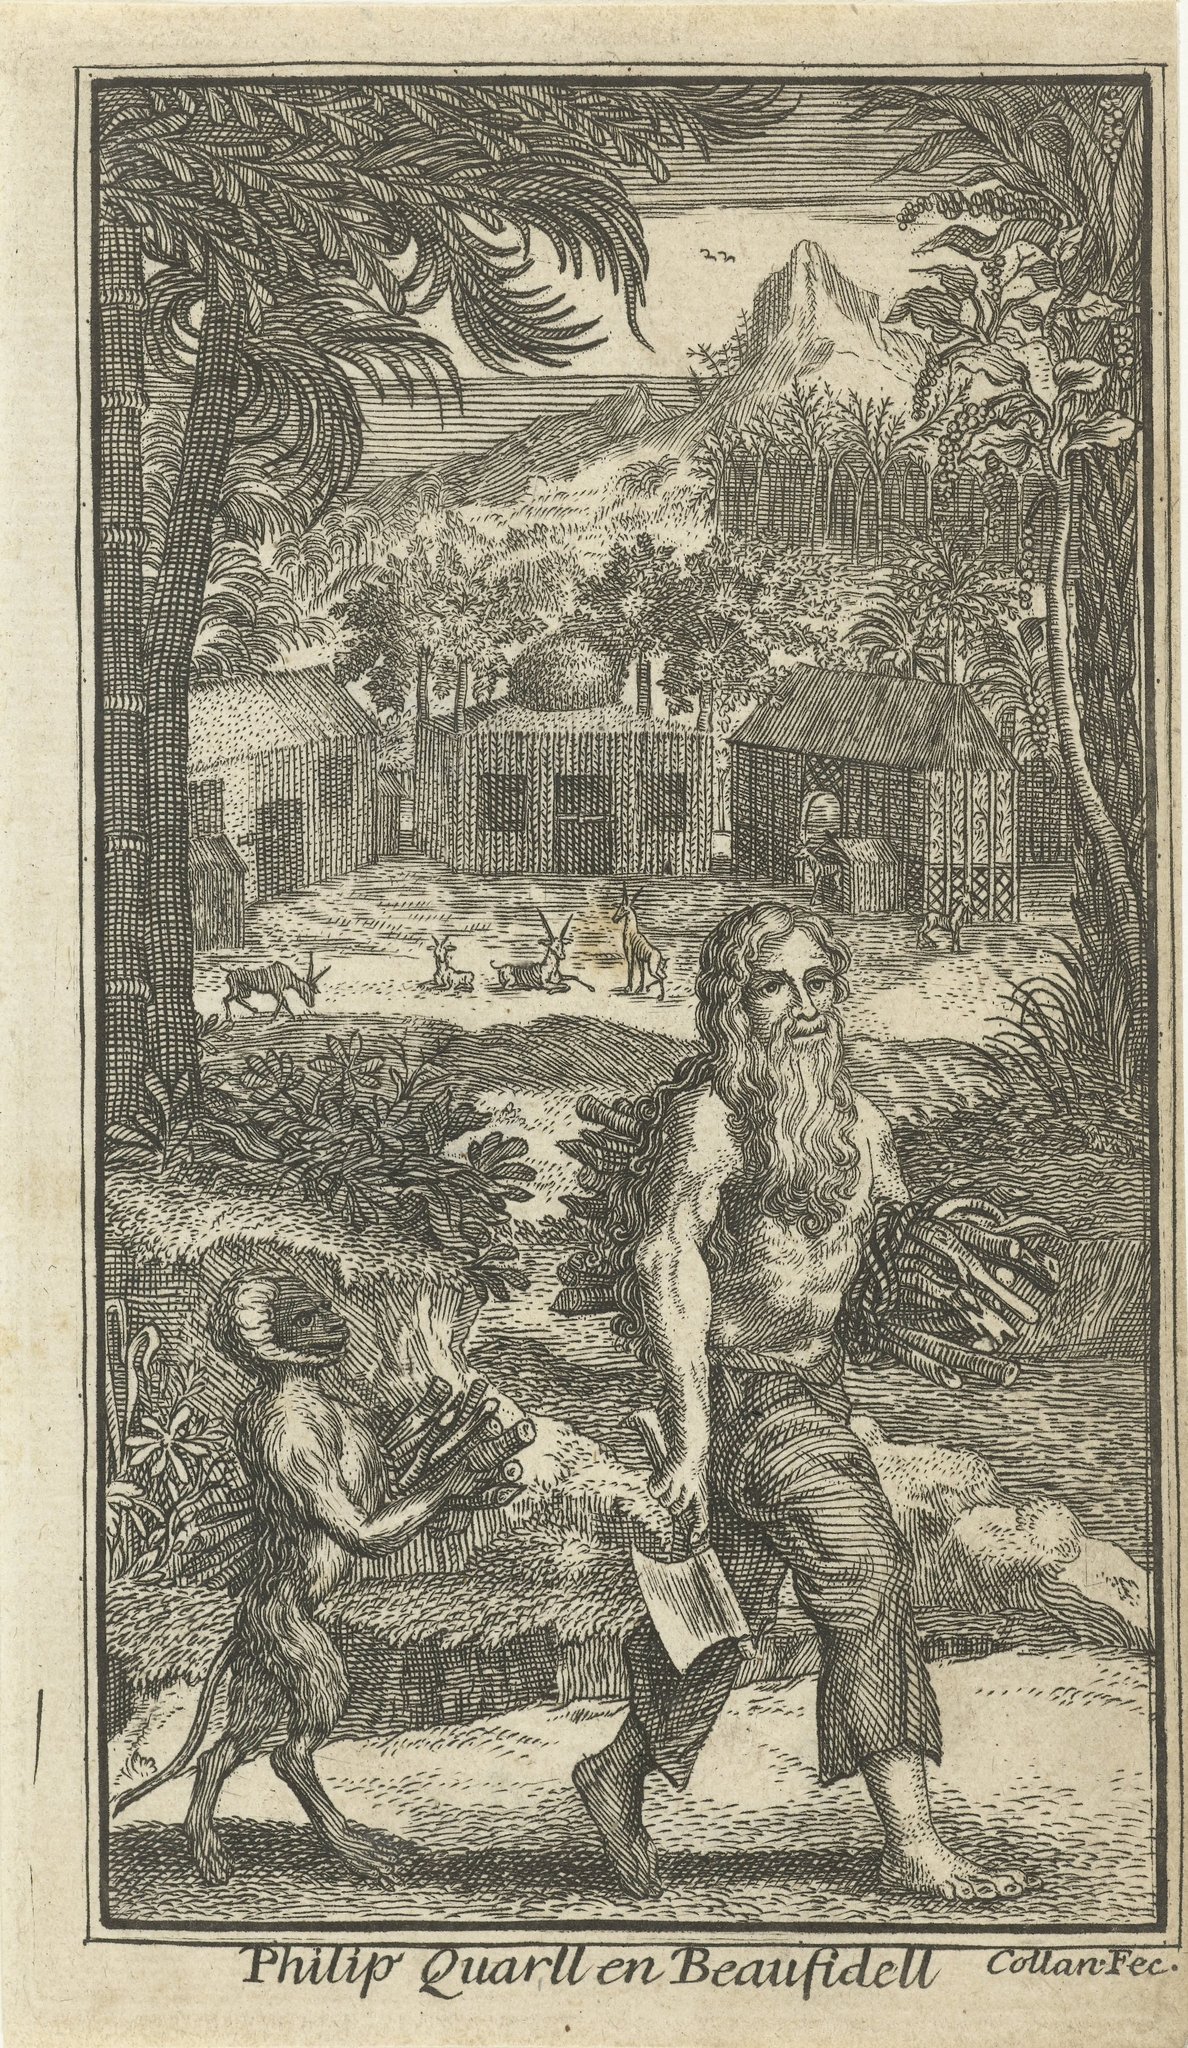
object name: print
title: Philipp Quarll en Beaufidell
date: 1728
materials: paper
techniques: engraving, etching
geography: rotterdam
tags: woodgathering, woodgatherer, monkeys, apes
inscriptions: collector's mark: Lugt 2228, collector's mark: Lugt 2760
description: Een kluizenaar met lang haar en baard is hout aan het verzamelen. Achter hem aan loopt een aap die eveneens een takkenbos draagt. Op de achtergrond is tussen de palmbomen een dorp met drie hutten te zien. Op het dorpsplein lopen geiten met lange rechte horens.